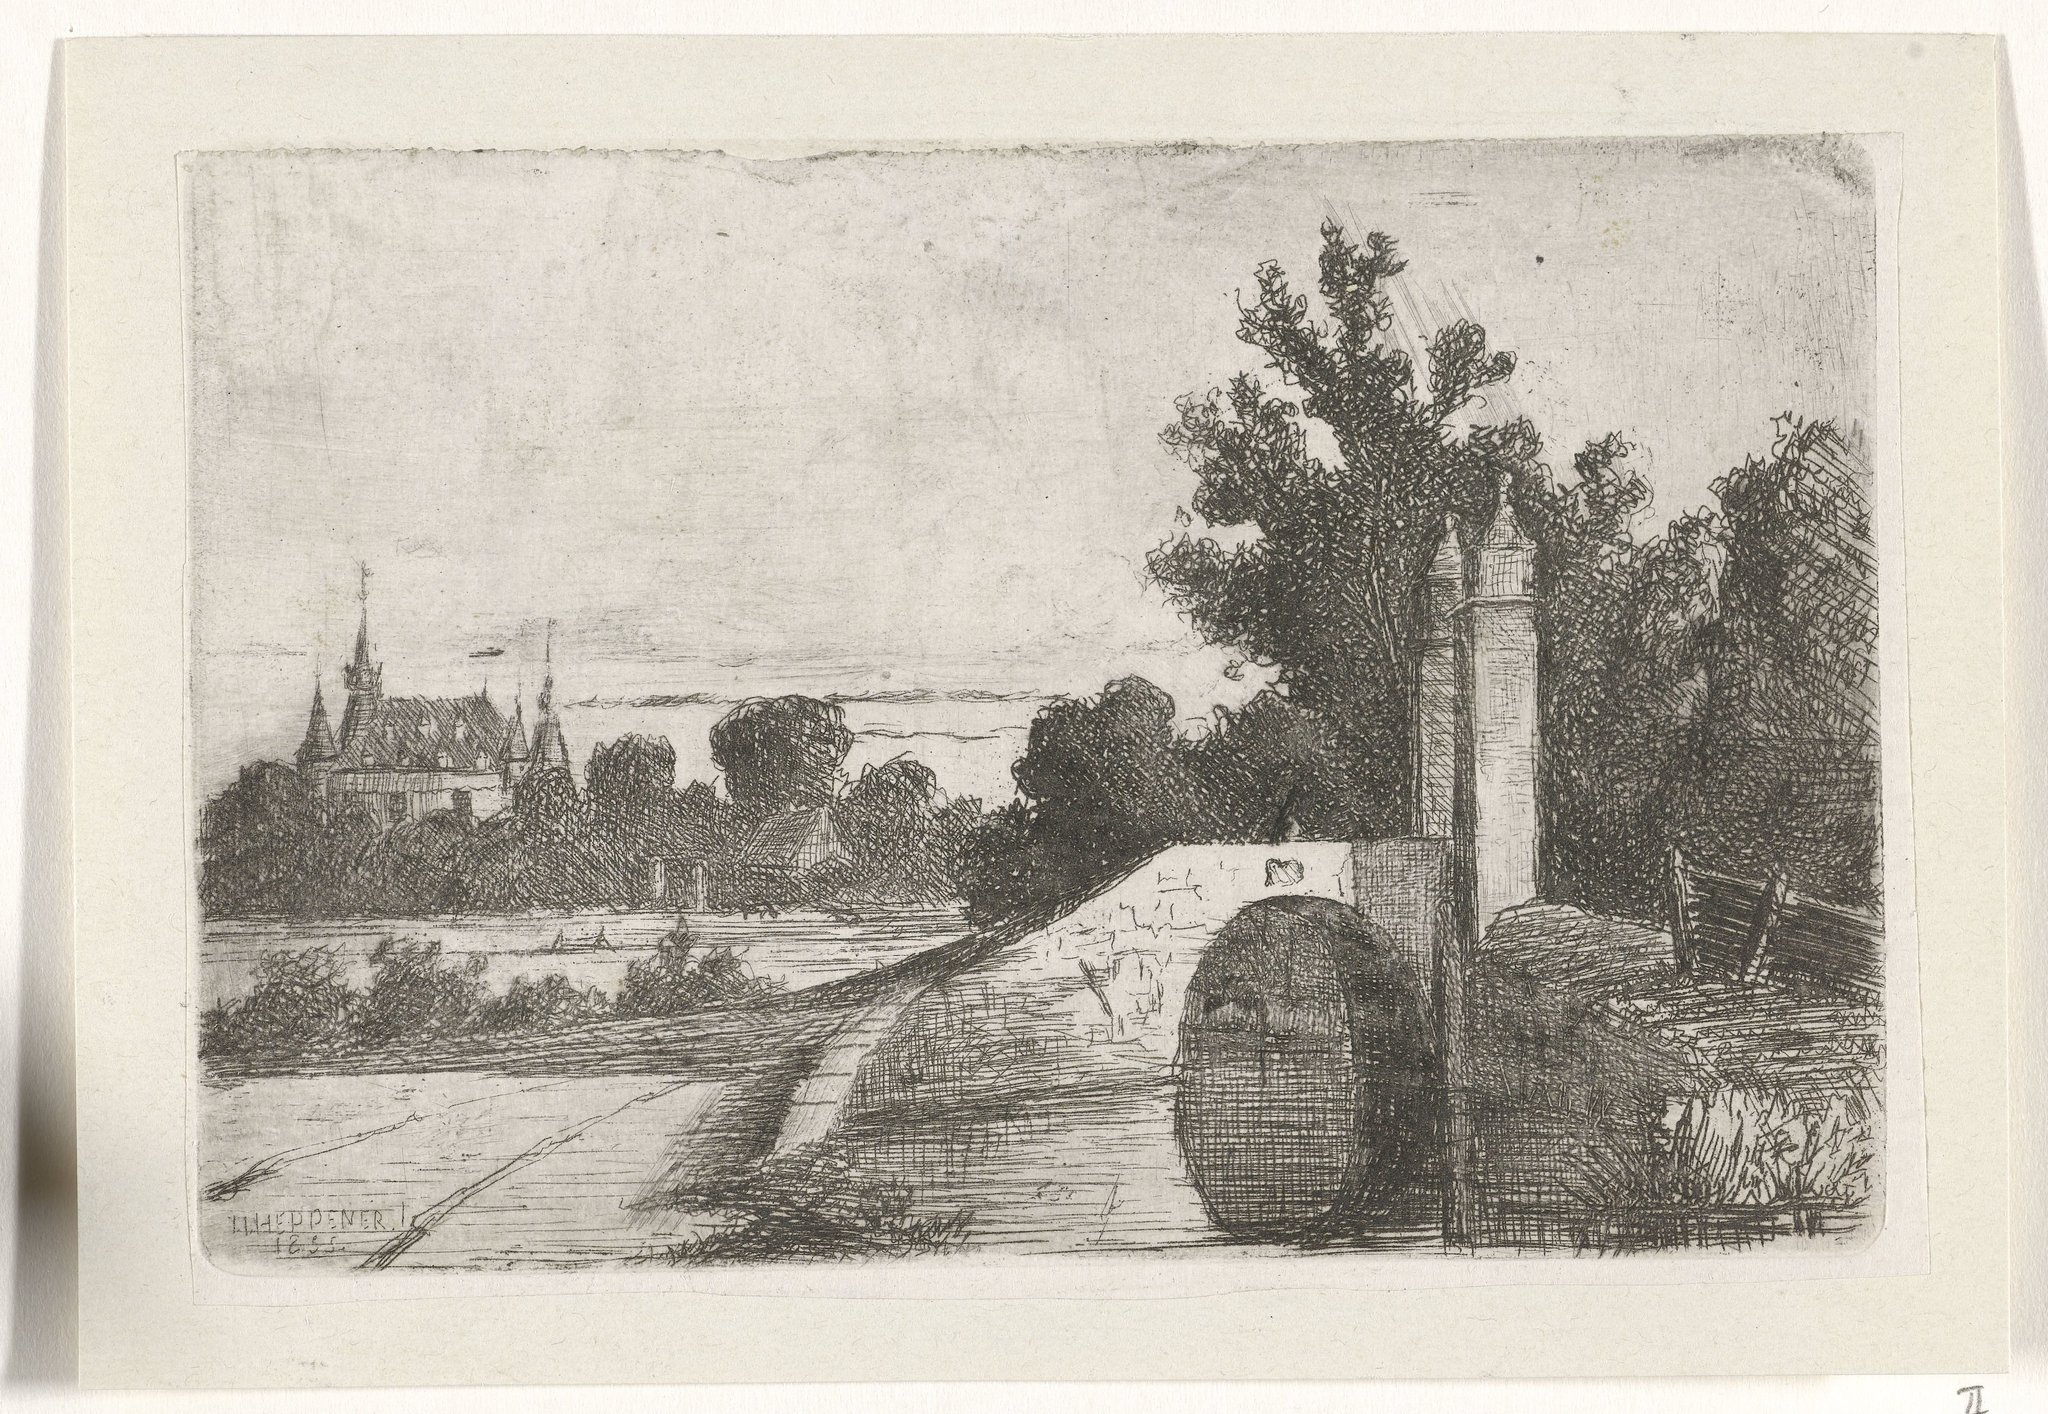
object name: print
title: Landschap met stenen brug en kasteel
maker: jan heppener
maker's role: print maker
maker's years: 1826-1898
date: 1855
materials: paper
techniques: drypoint, etching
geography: the hague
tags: landscape with bridge, viaduct or aqueduct, landscape with tower or castle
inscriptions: collector's mark: Lugt 2228